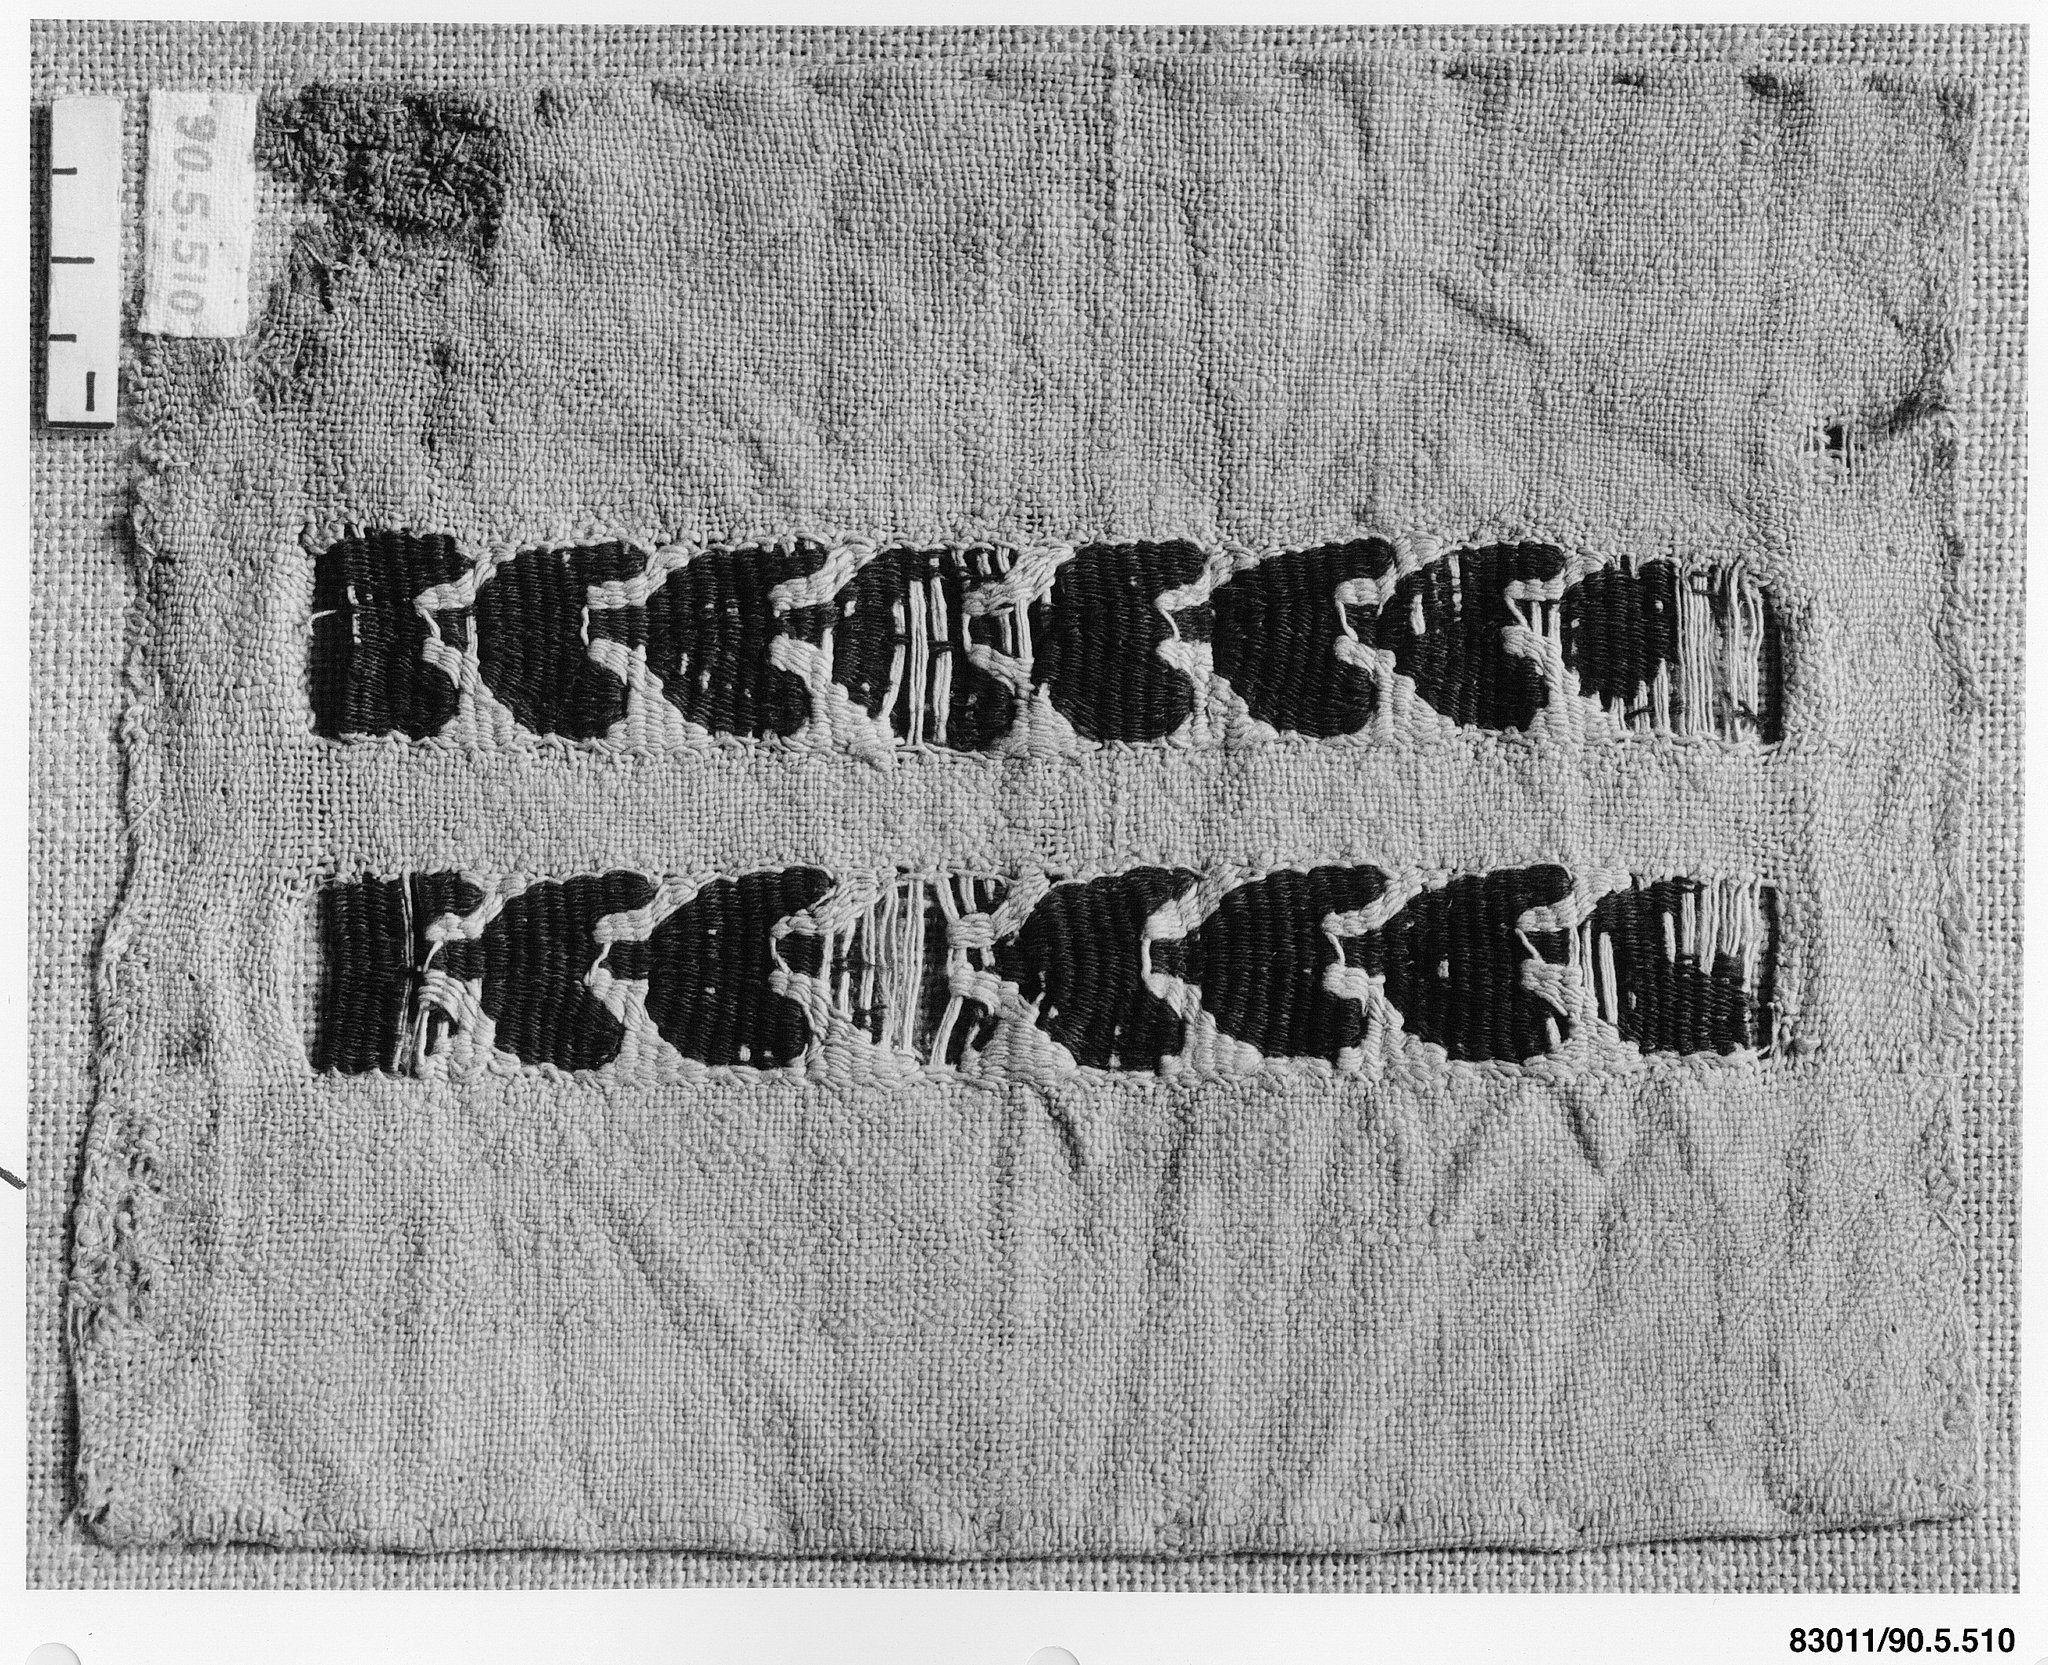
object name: textile fragment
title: Fragment of a Sleeve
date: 201-400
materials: linen, wool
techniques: weave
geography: egypt